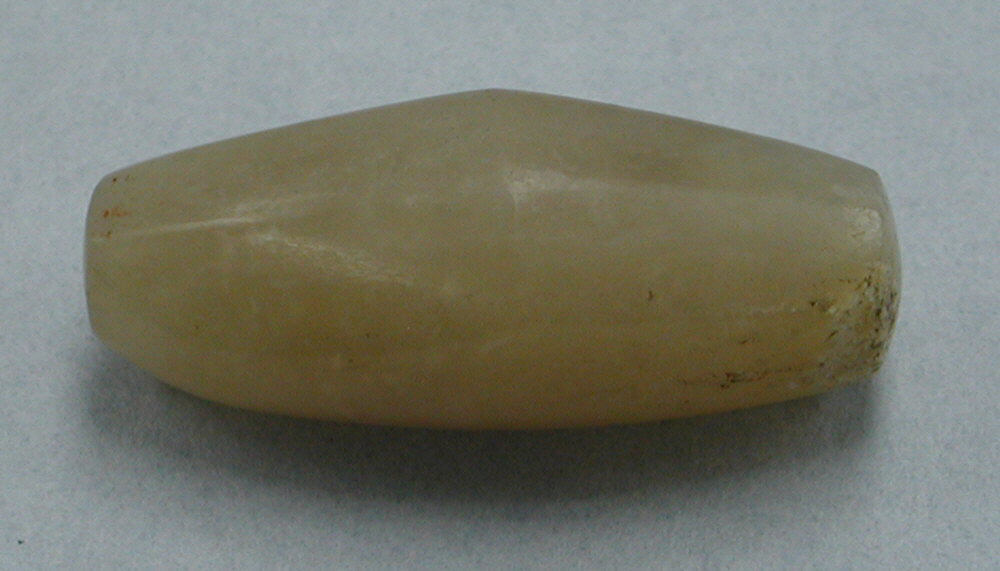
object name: ritual stone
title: Stone Pulidor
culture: mexican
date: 1501-1600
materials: stone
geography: mexico